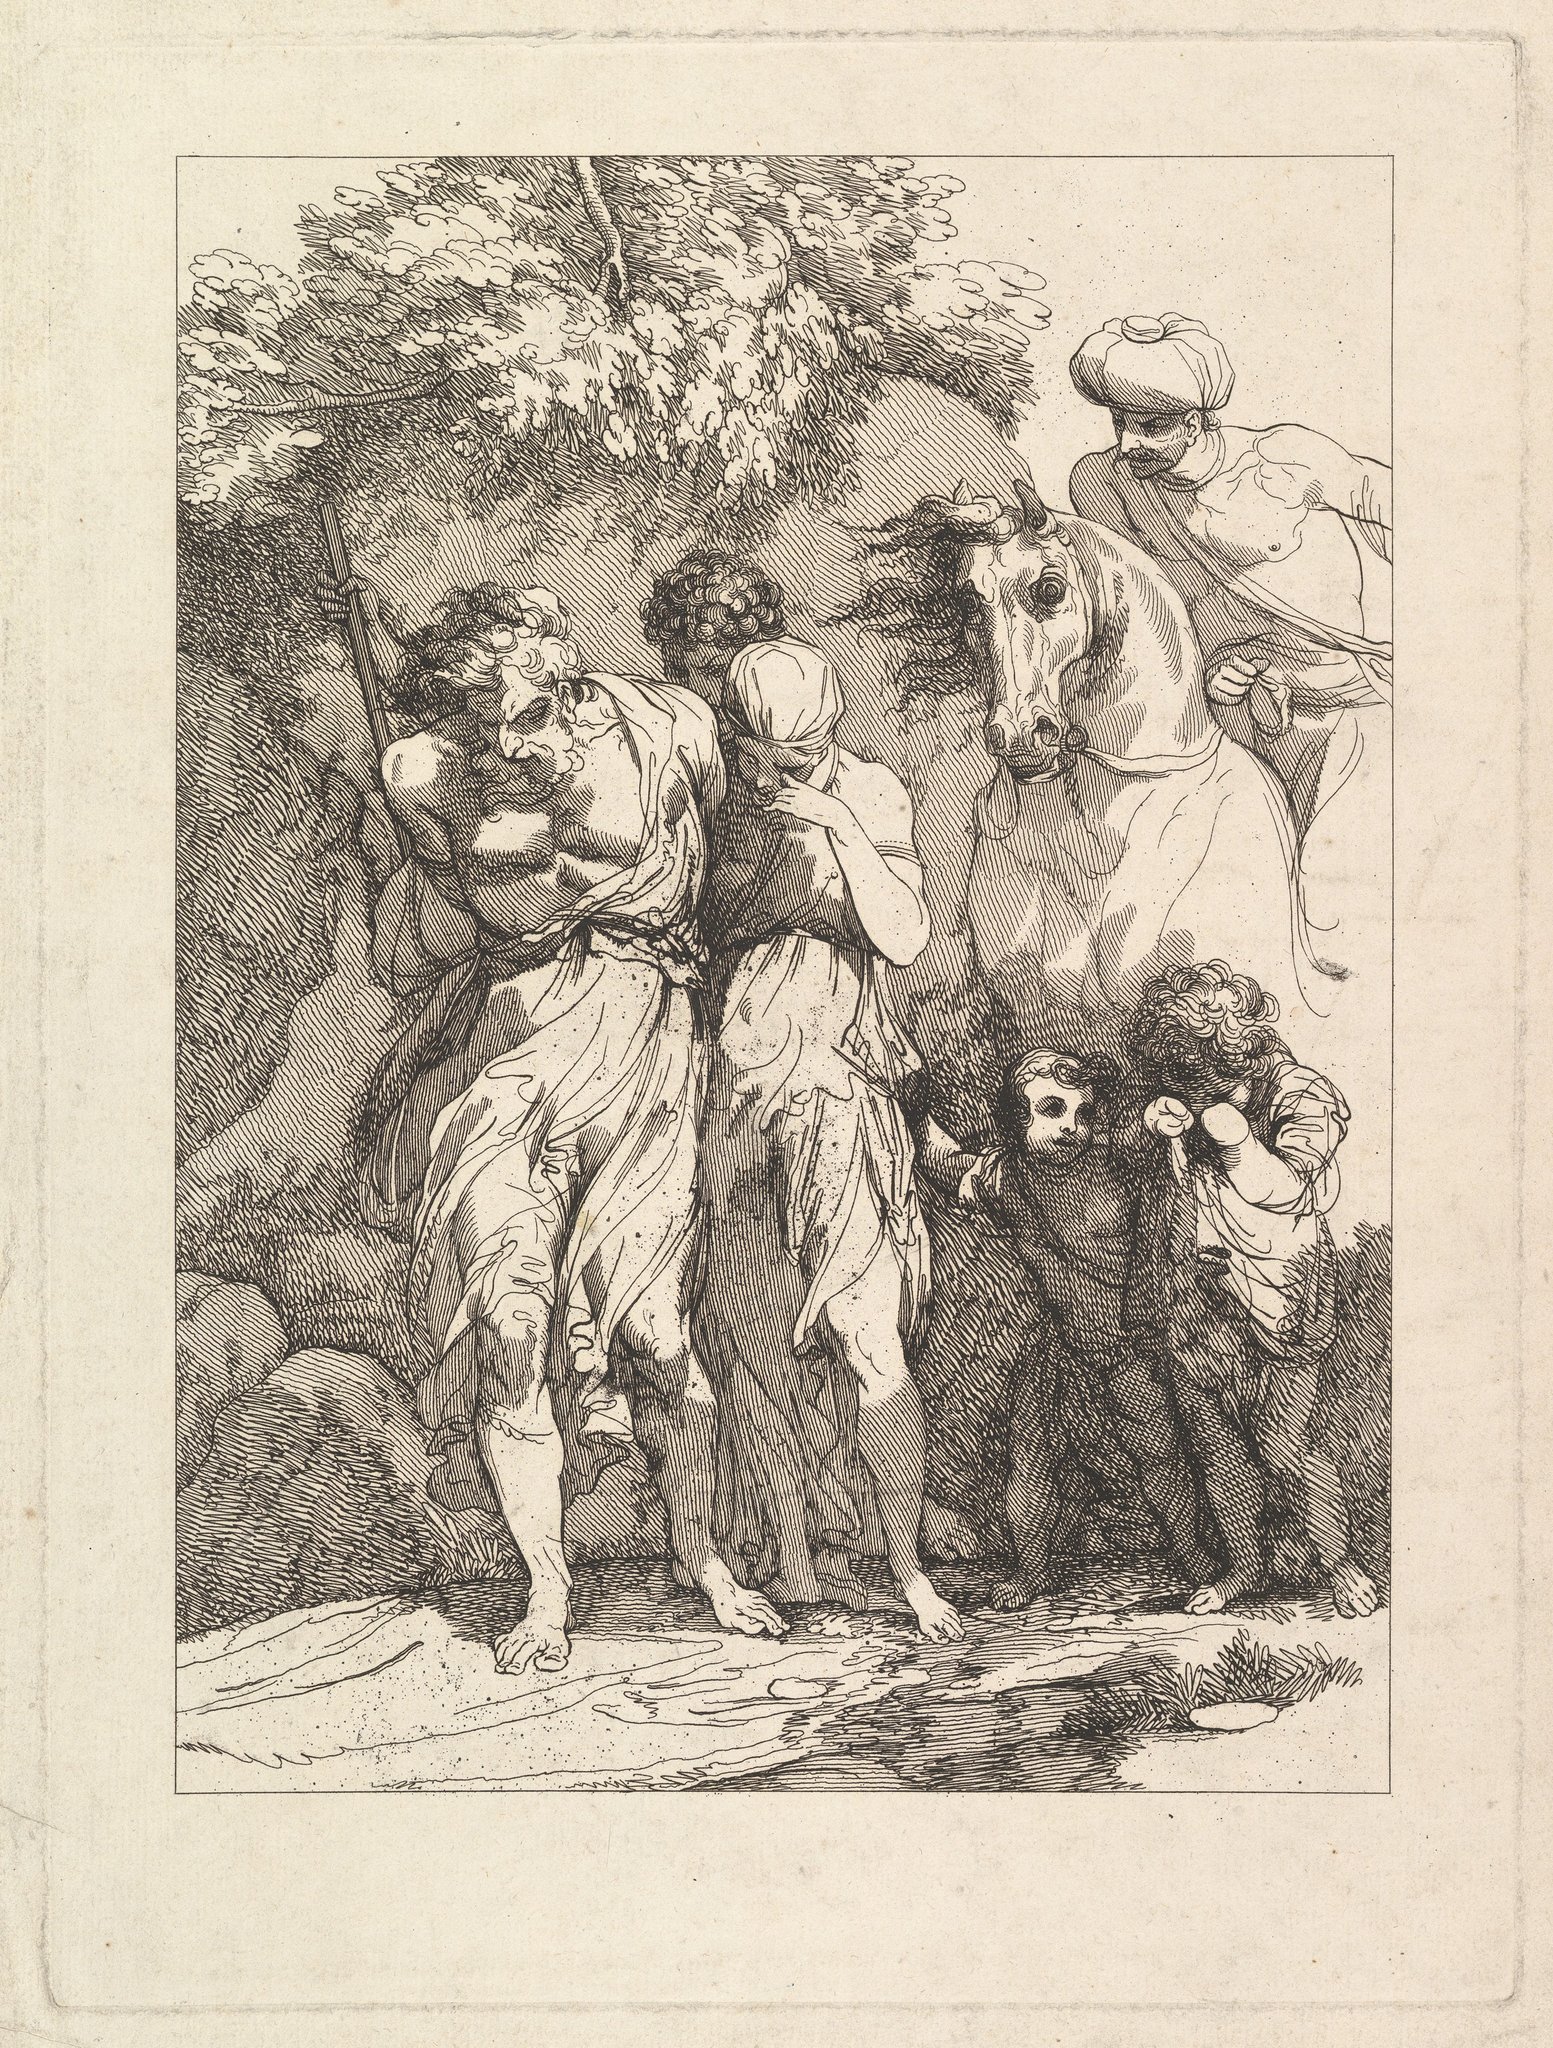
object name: print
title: A Captive Family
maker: robert blyth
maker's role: artist and publisher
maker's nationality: british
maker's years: 1750-1784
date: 1783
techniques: etching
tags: prisoners,men,women,horses